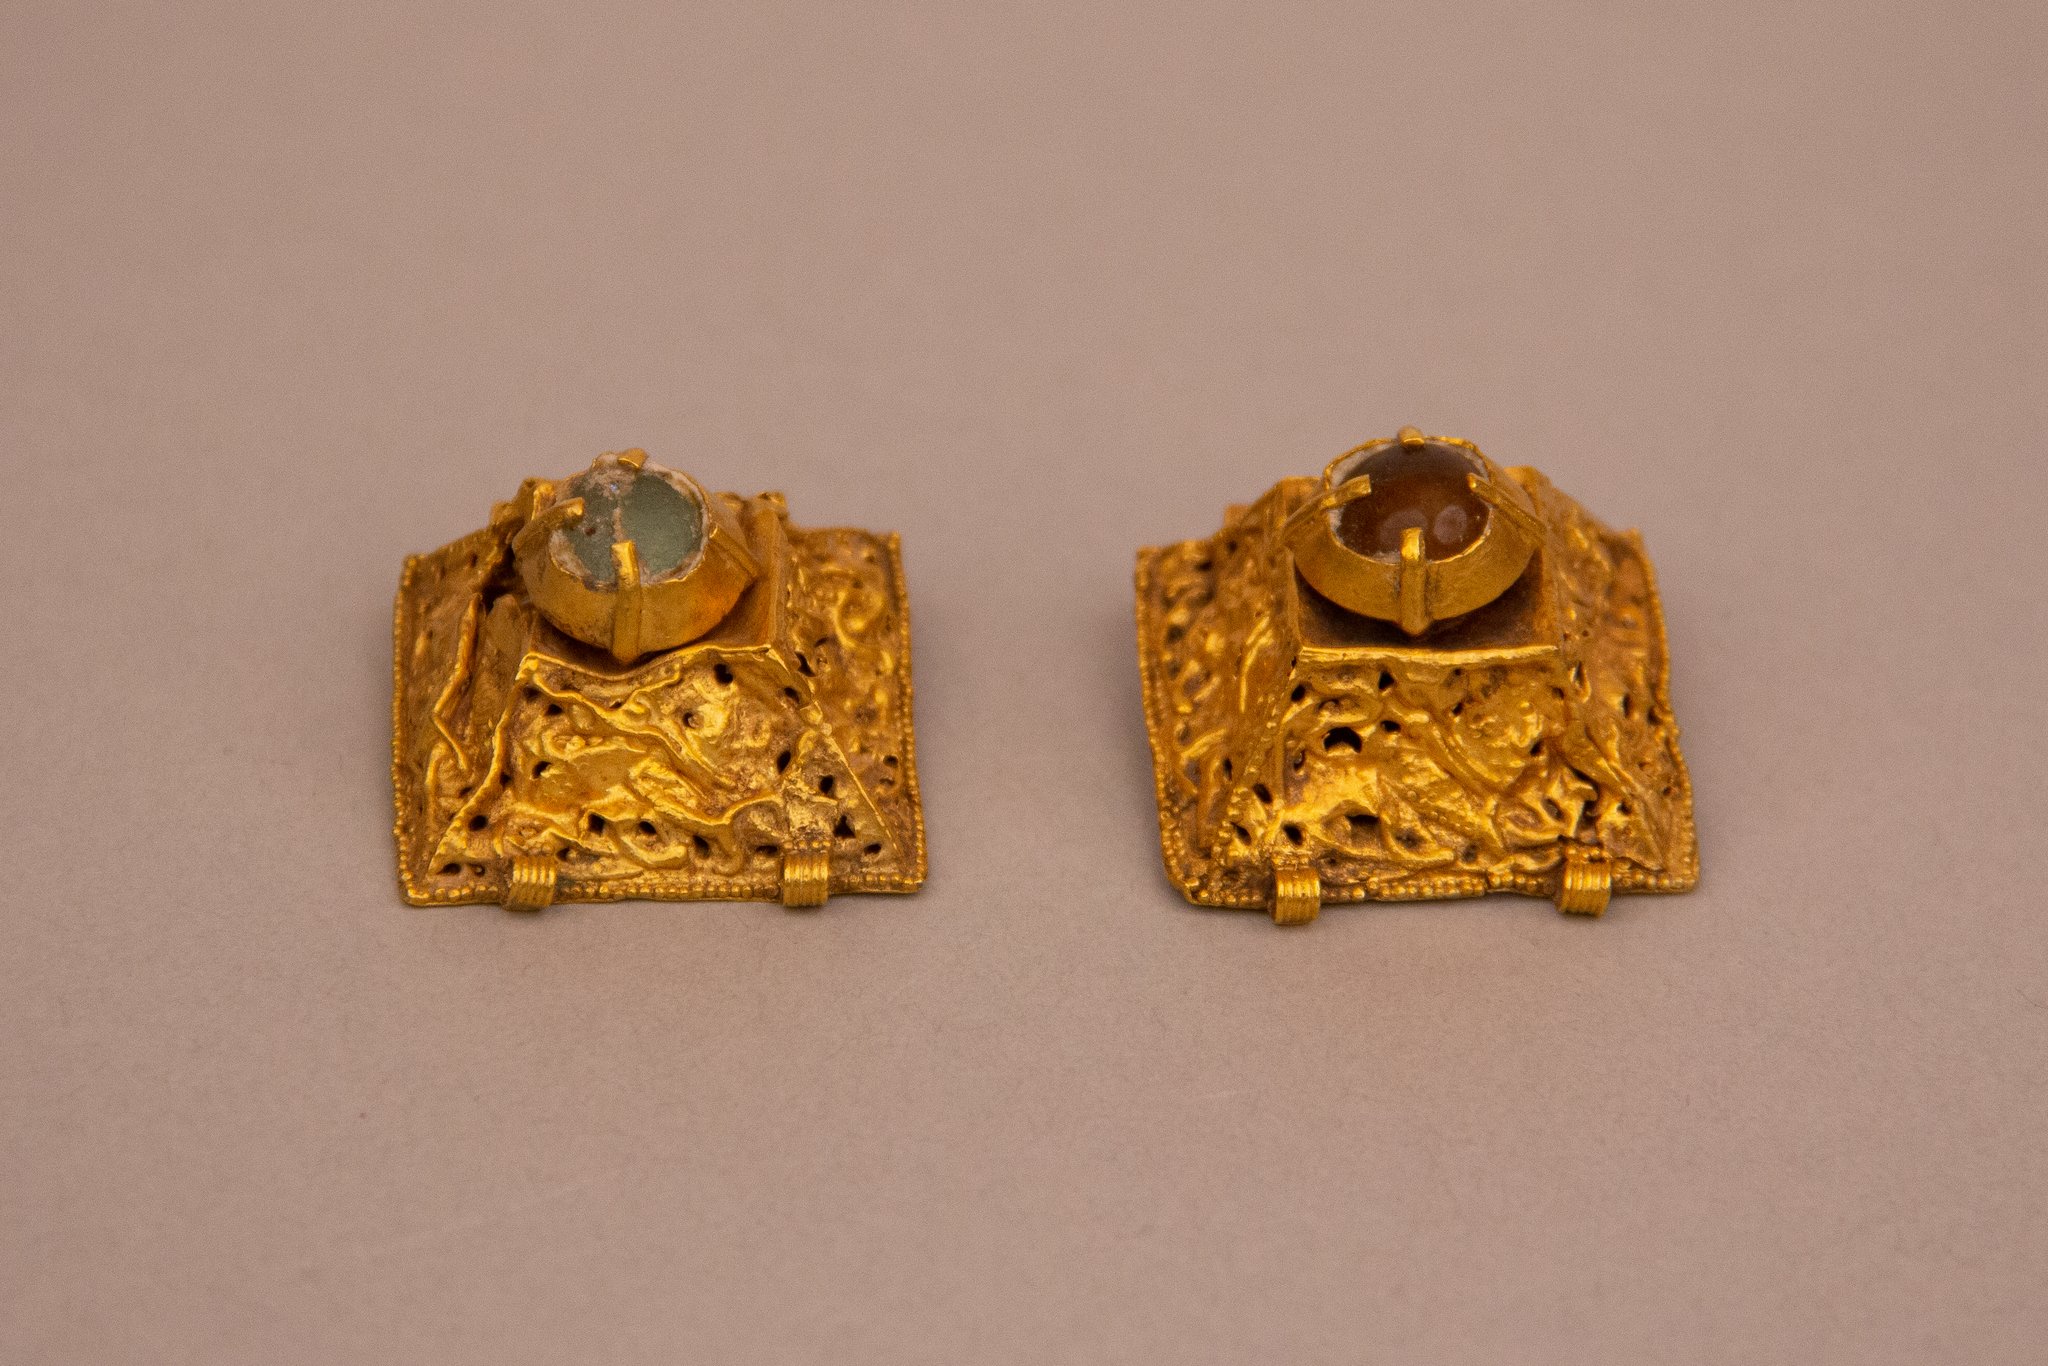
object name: ornament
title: Ornament, One of a Pair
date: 1101-1300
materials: glass, gold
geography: iran